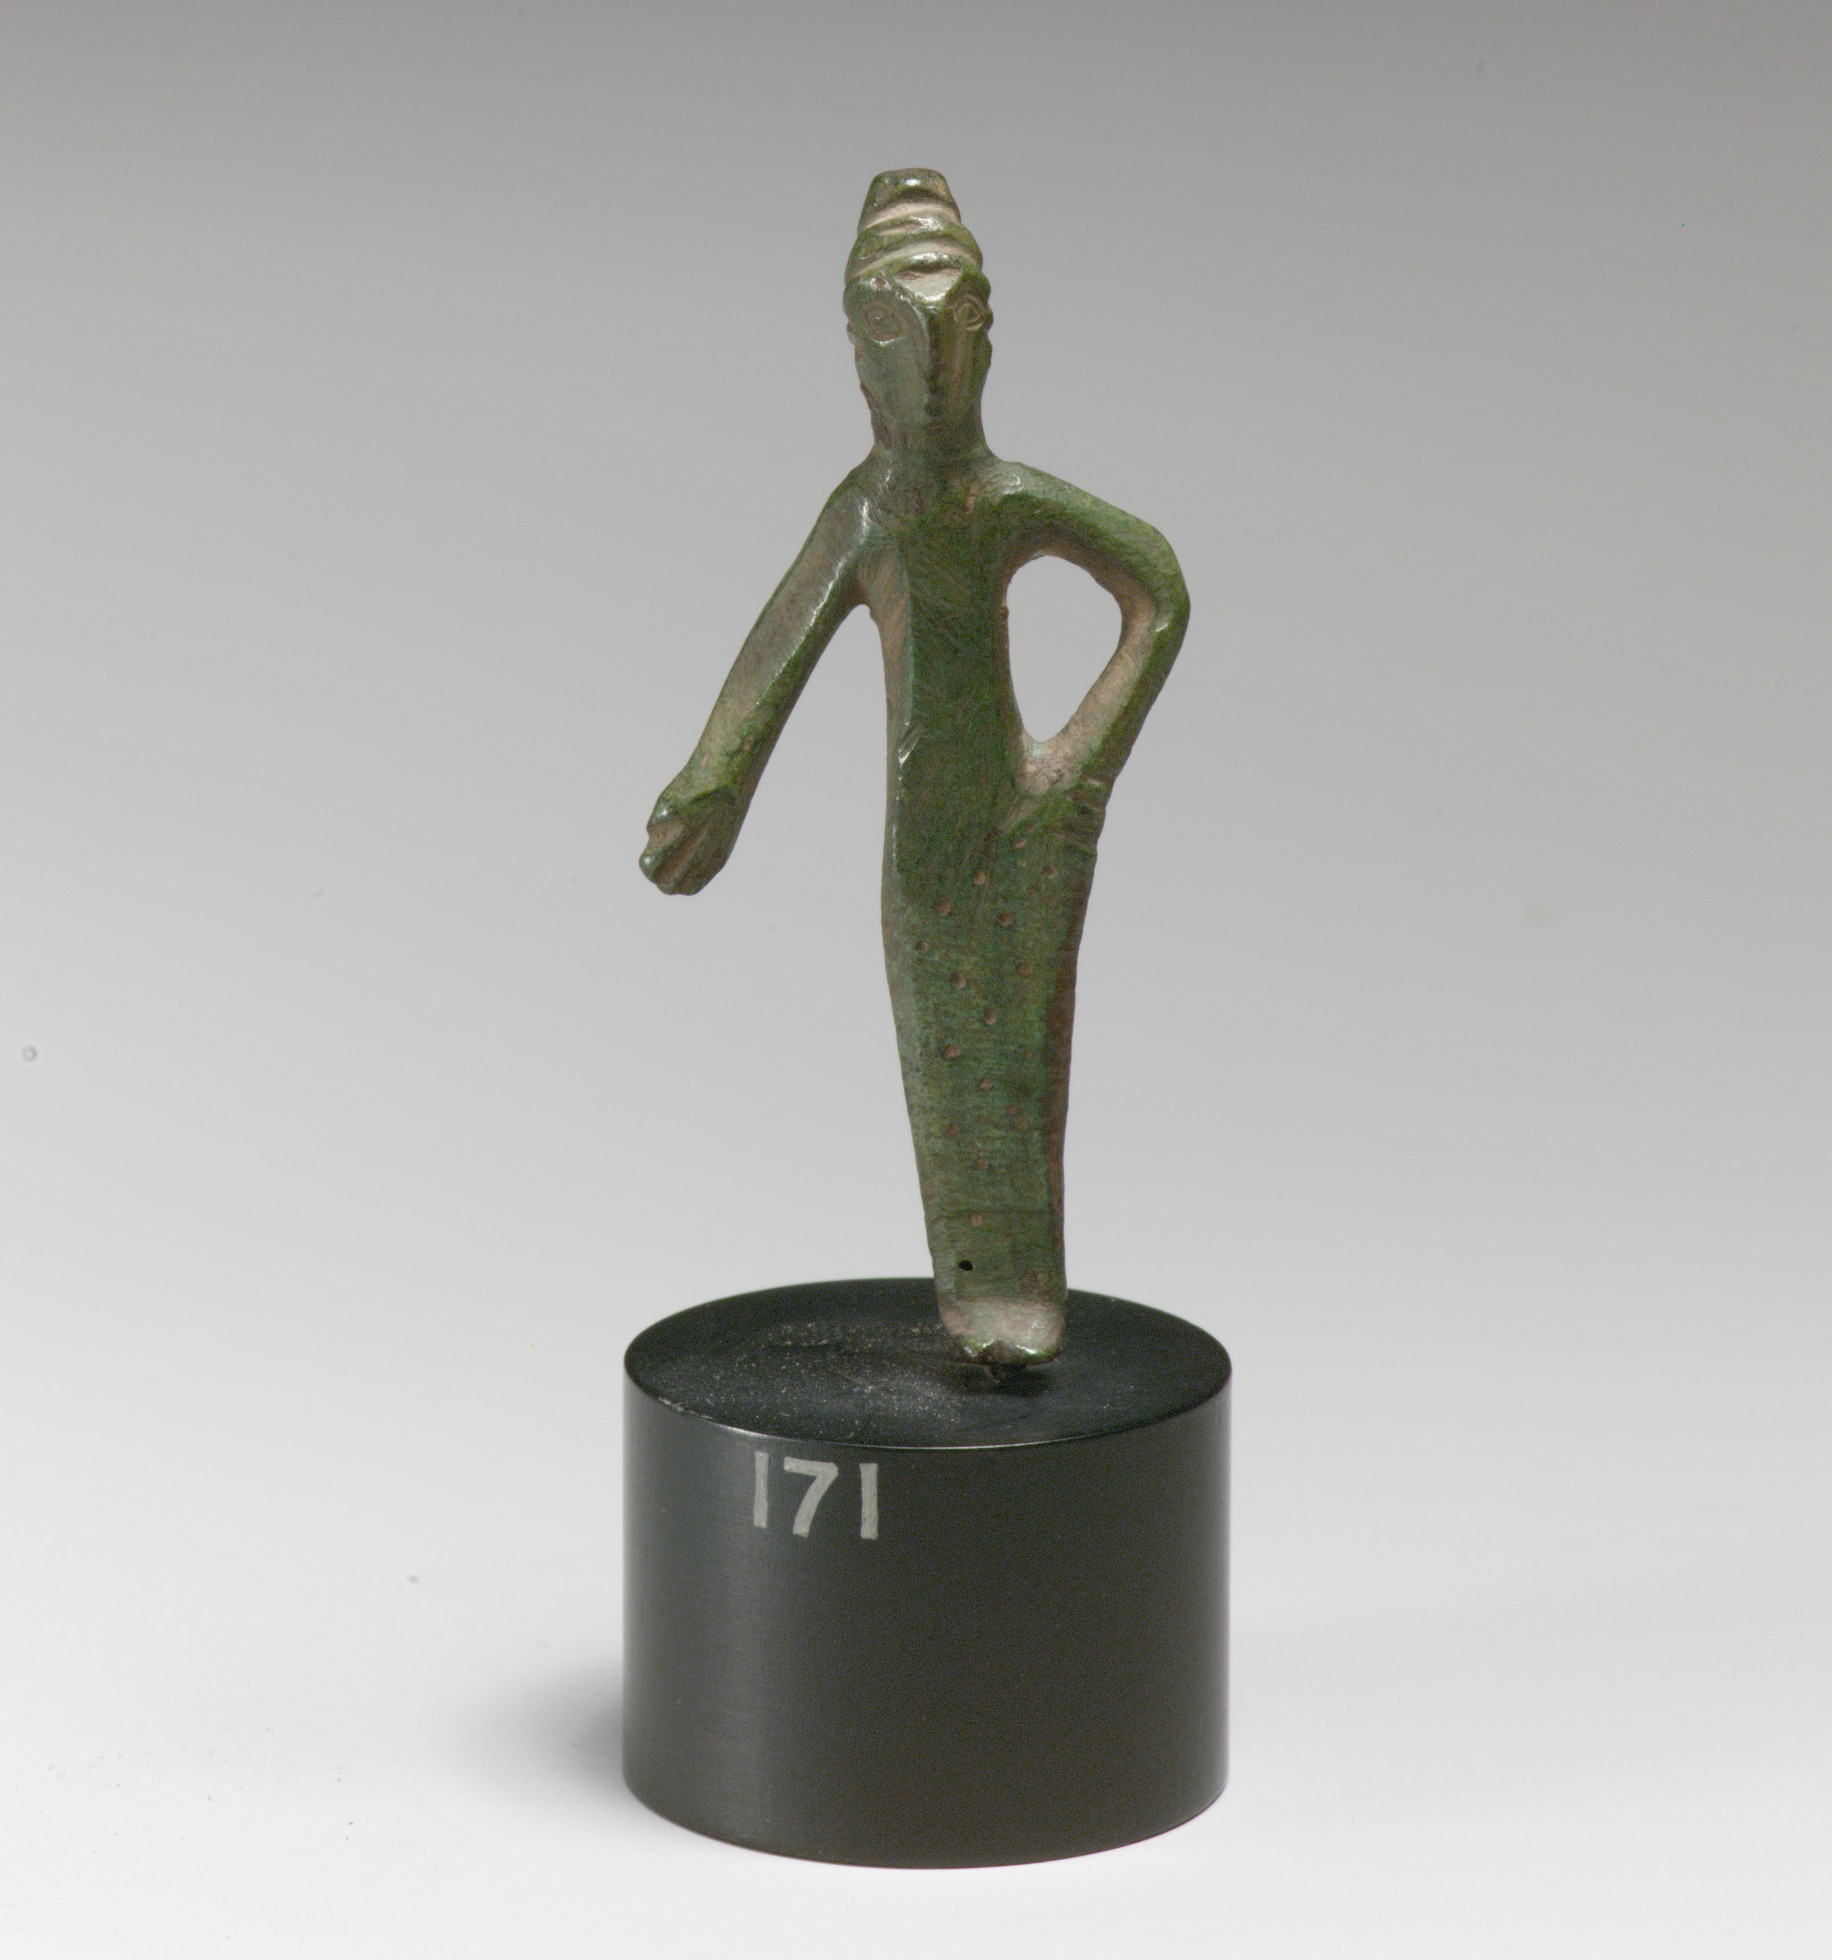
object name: statuette of a woman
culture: etruscan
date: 600-501 BCE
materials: bronze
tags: women